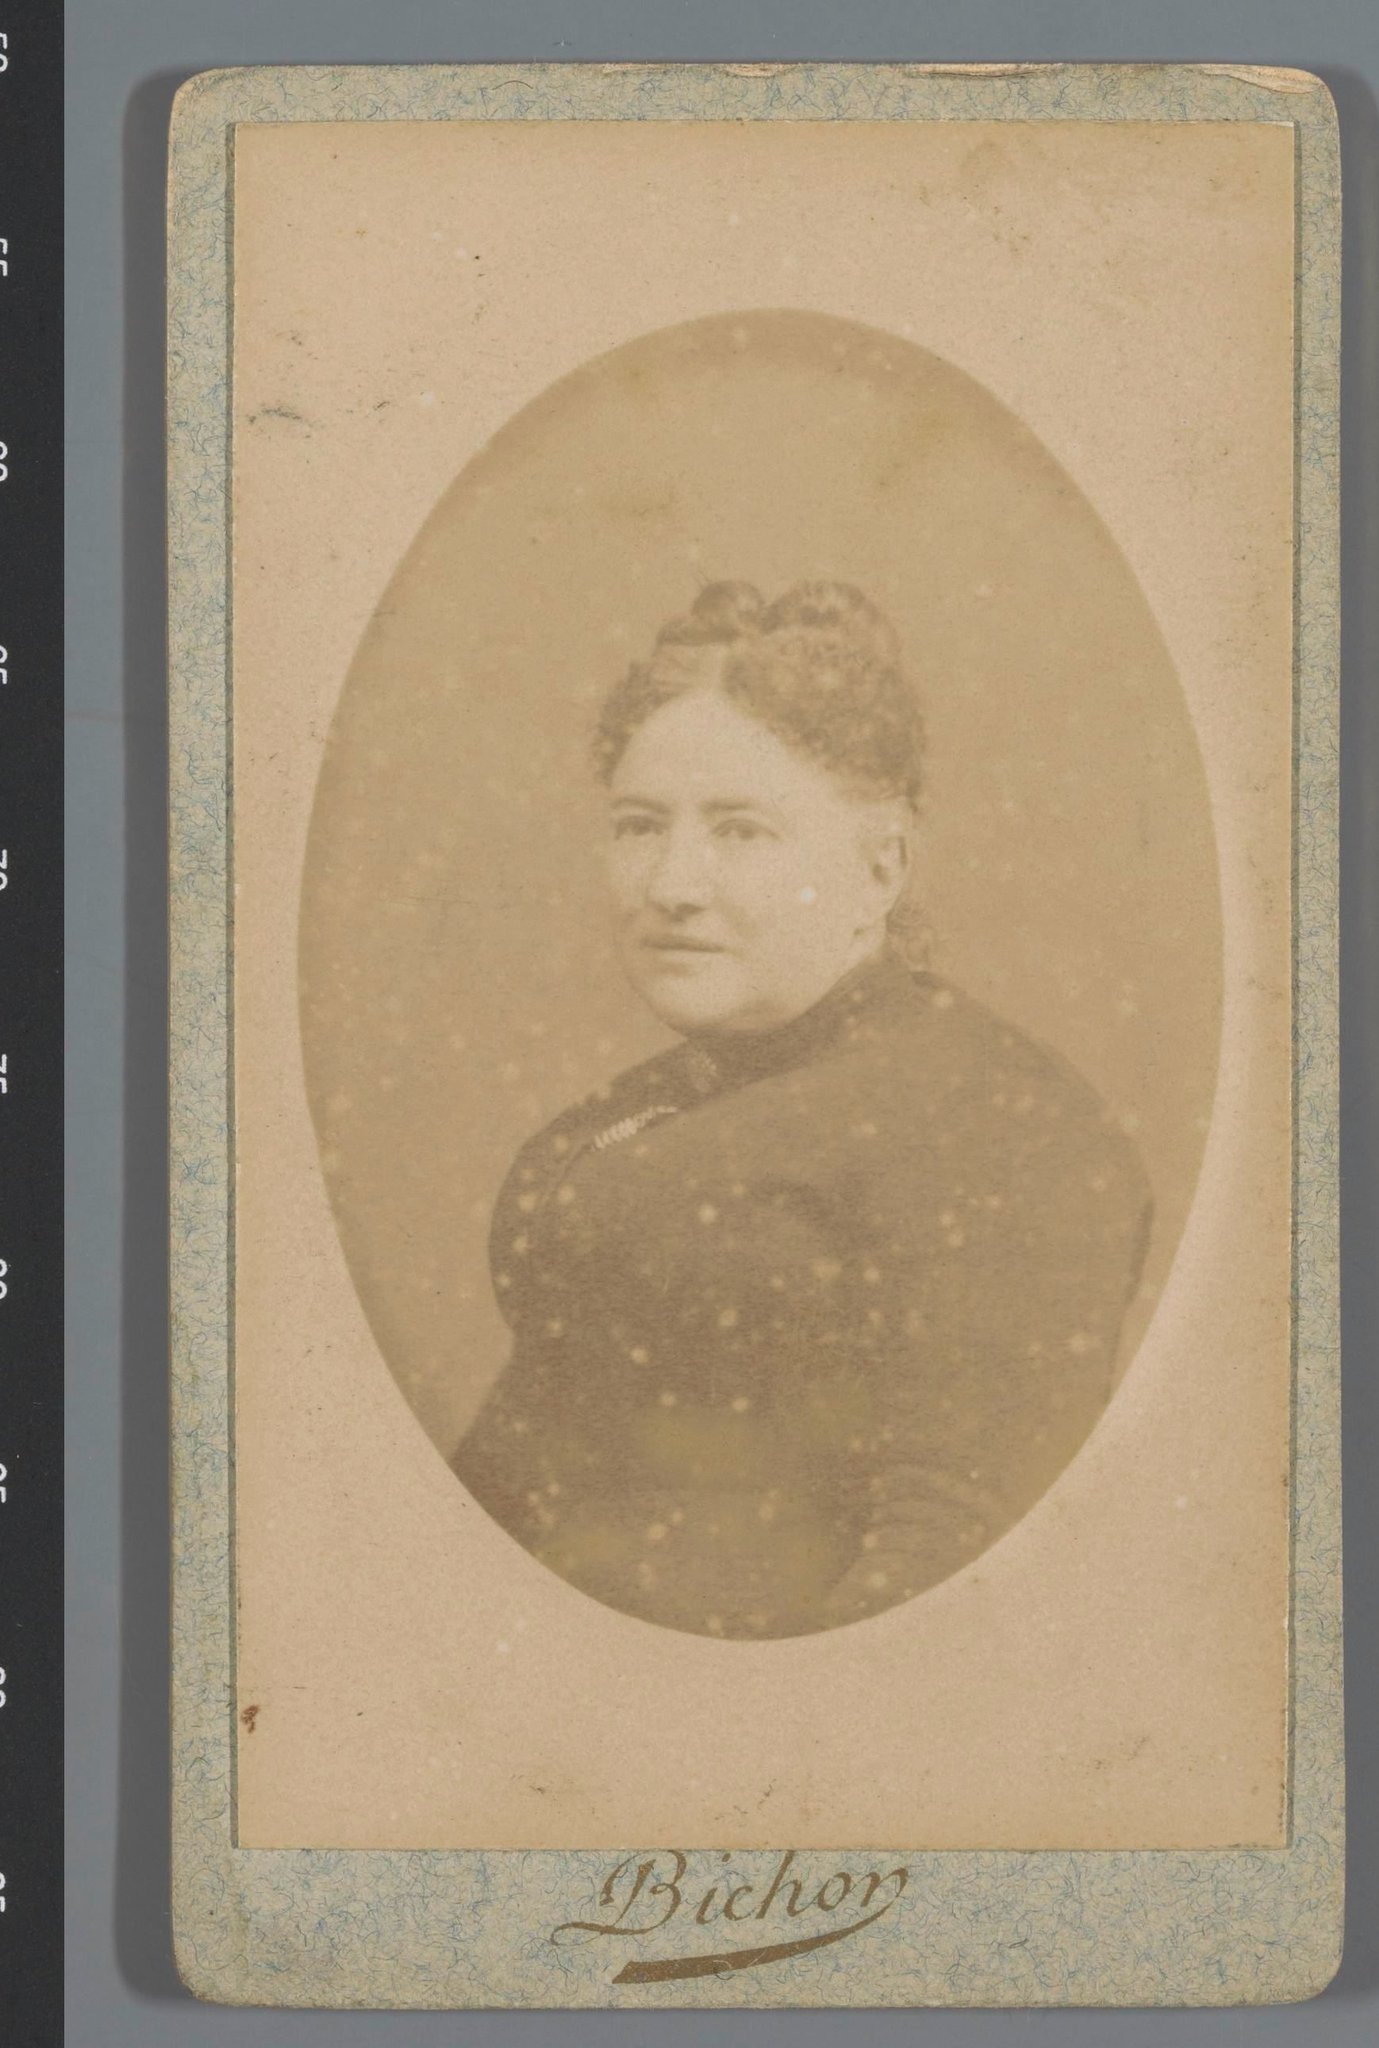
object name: semi enamel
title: Portret van een onbekende vrouw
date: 1886-1911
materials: cardboard, celluloid, paper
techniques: albumen print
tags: adult woman, anonymous historical person portrayed